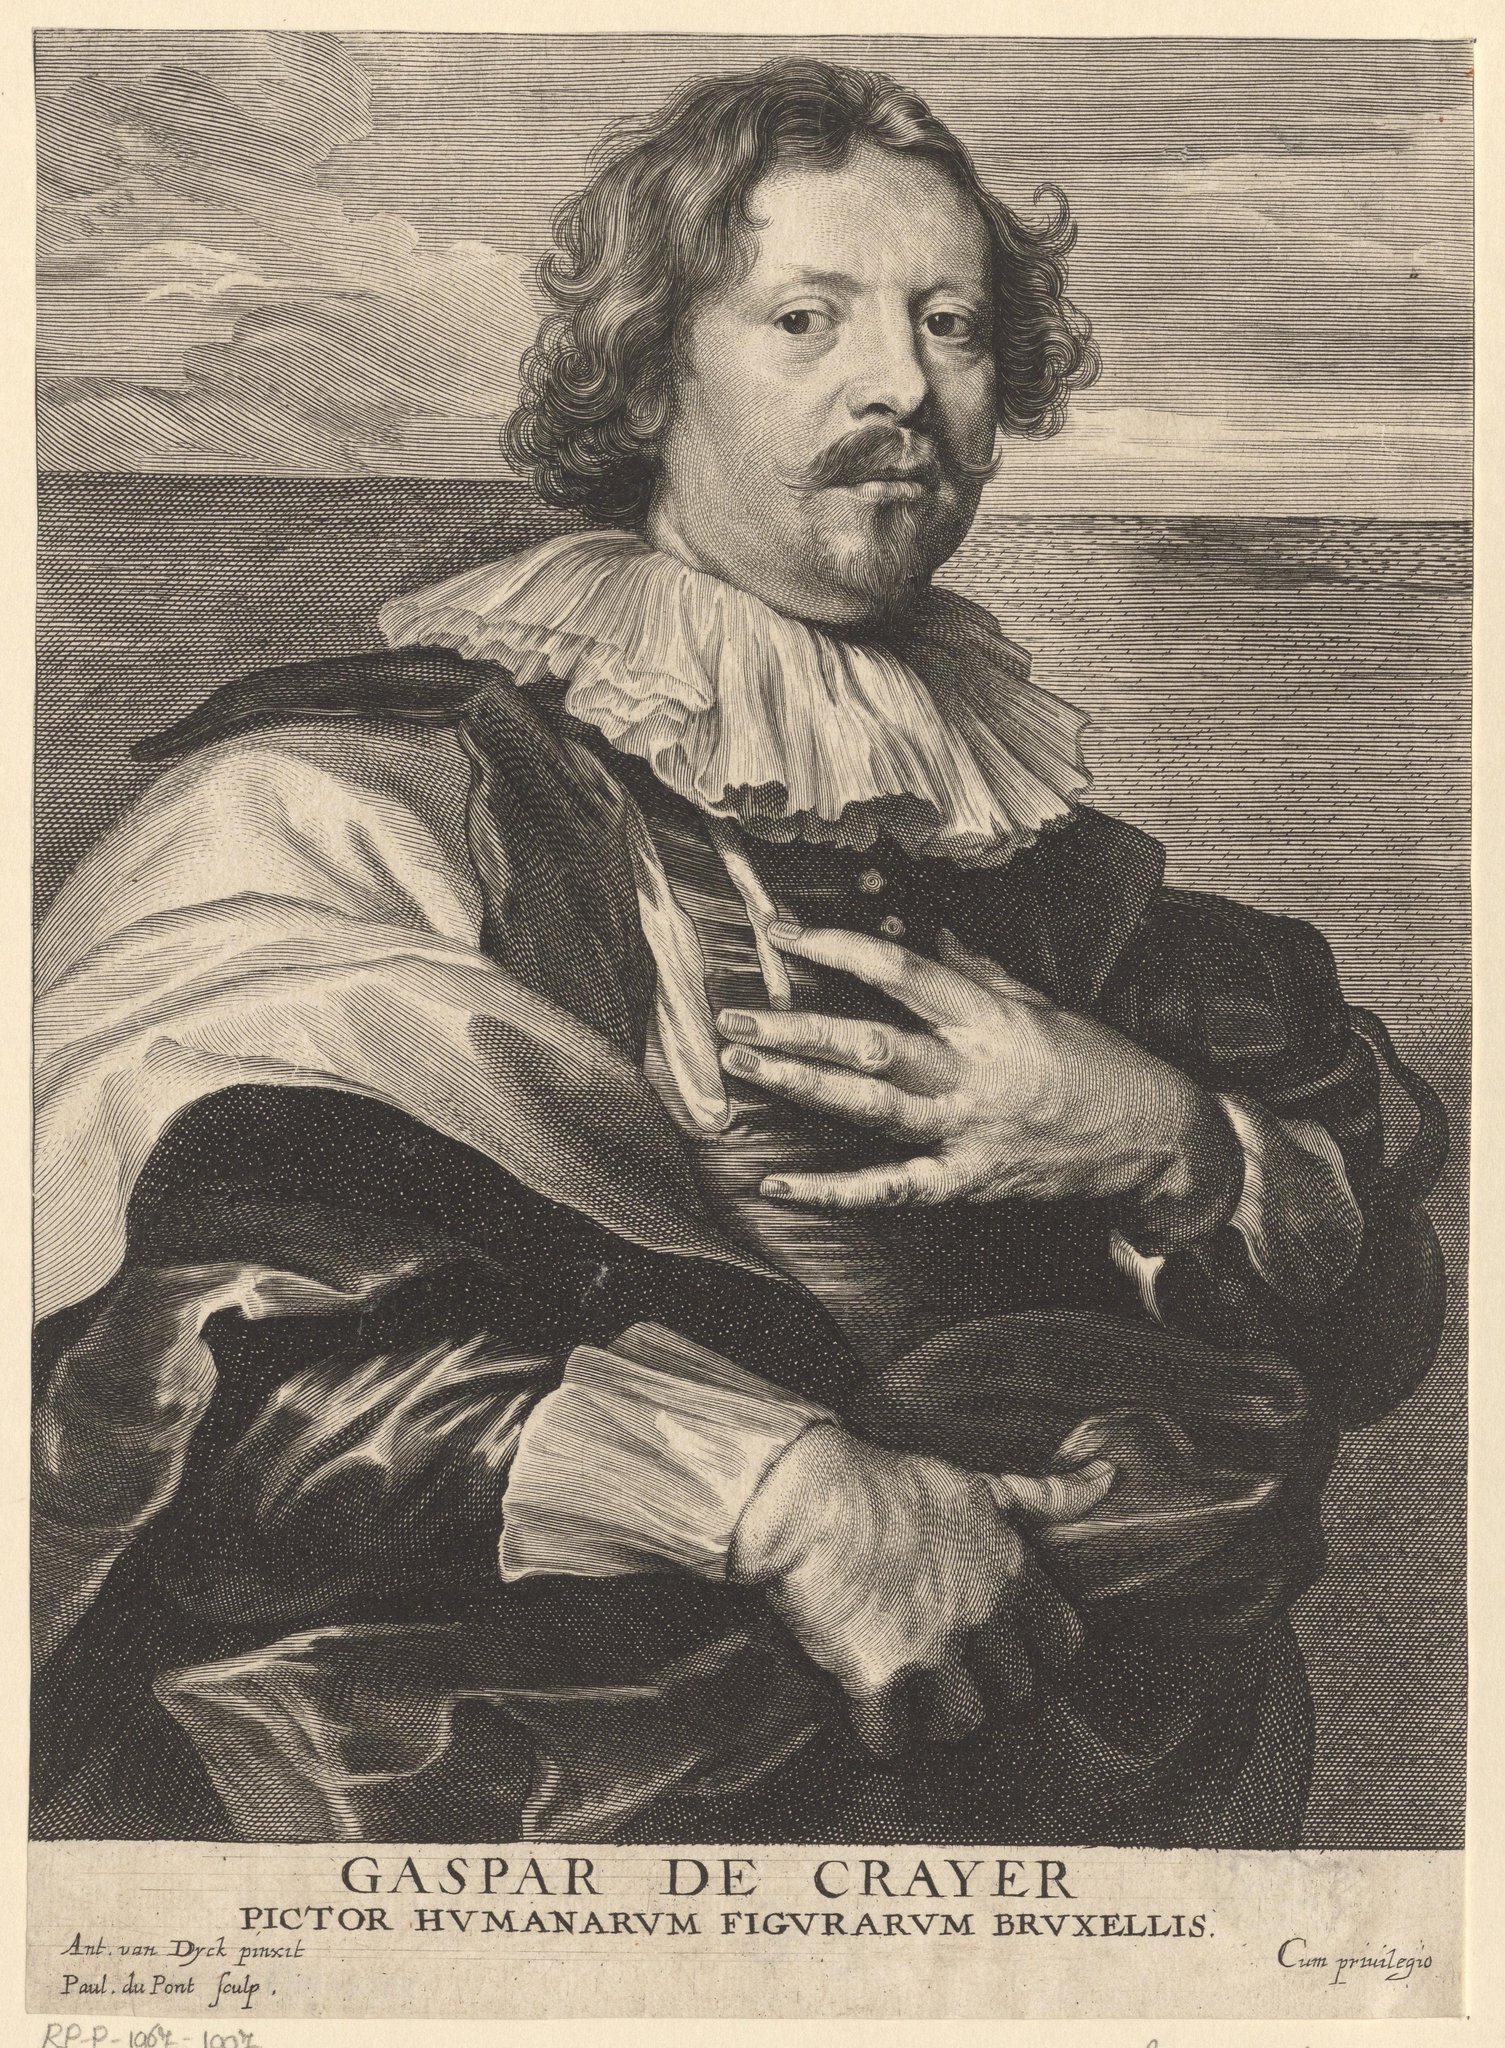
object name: print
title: Portret van Gaspar de Crayer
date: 1613-1658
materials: paper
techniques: engraving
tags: antwerp, print maker, gaspar de crayer, historical persons